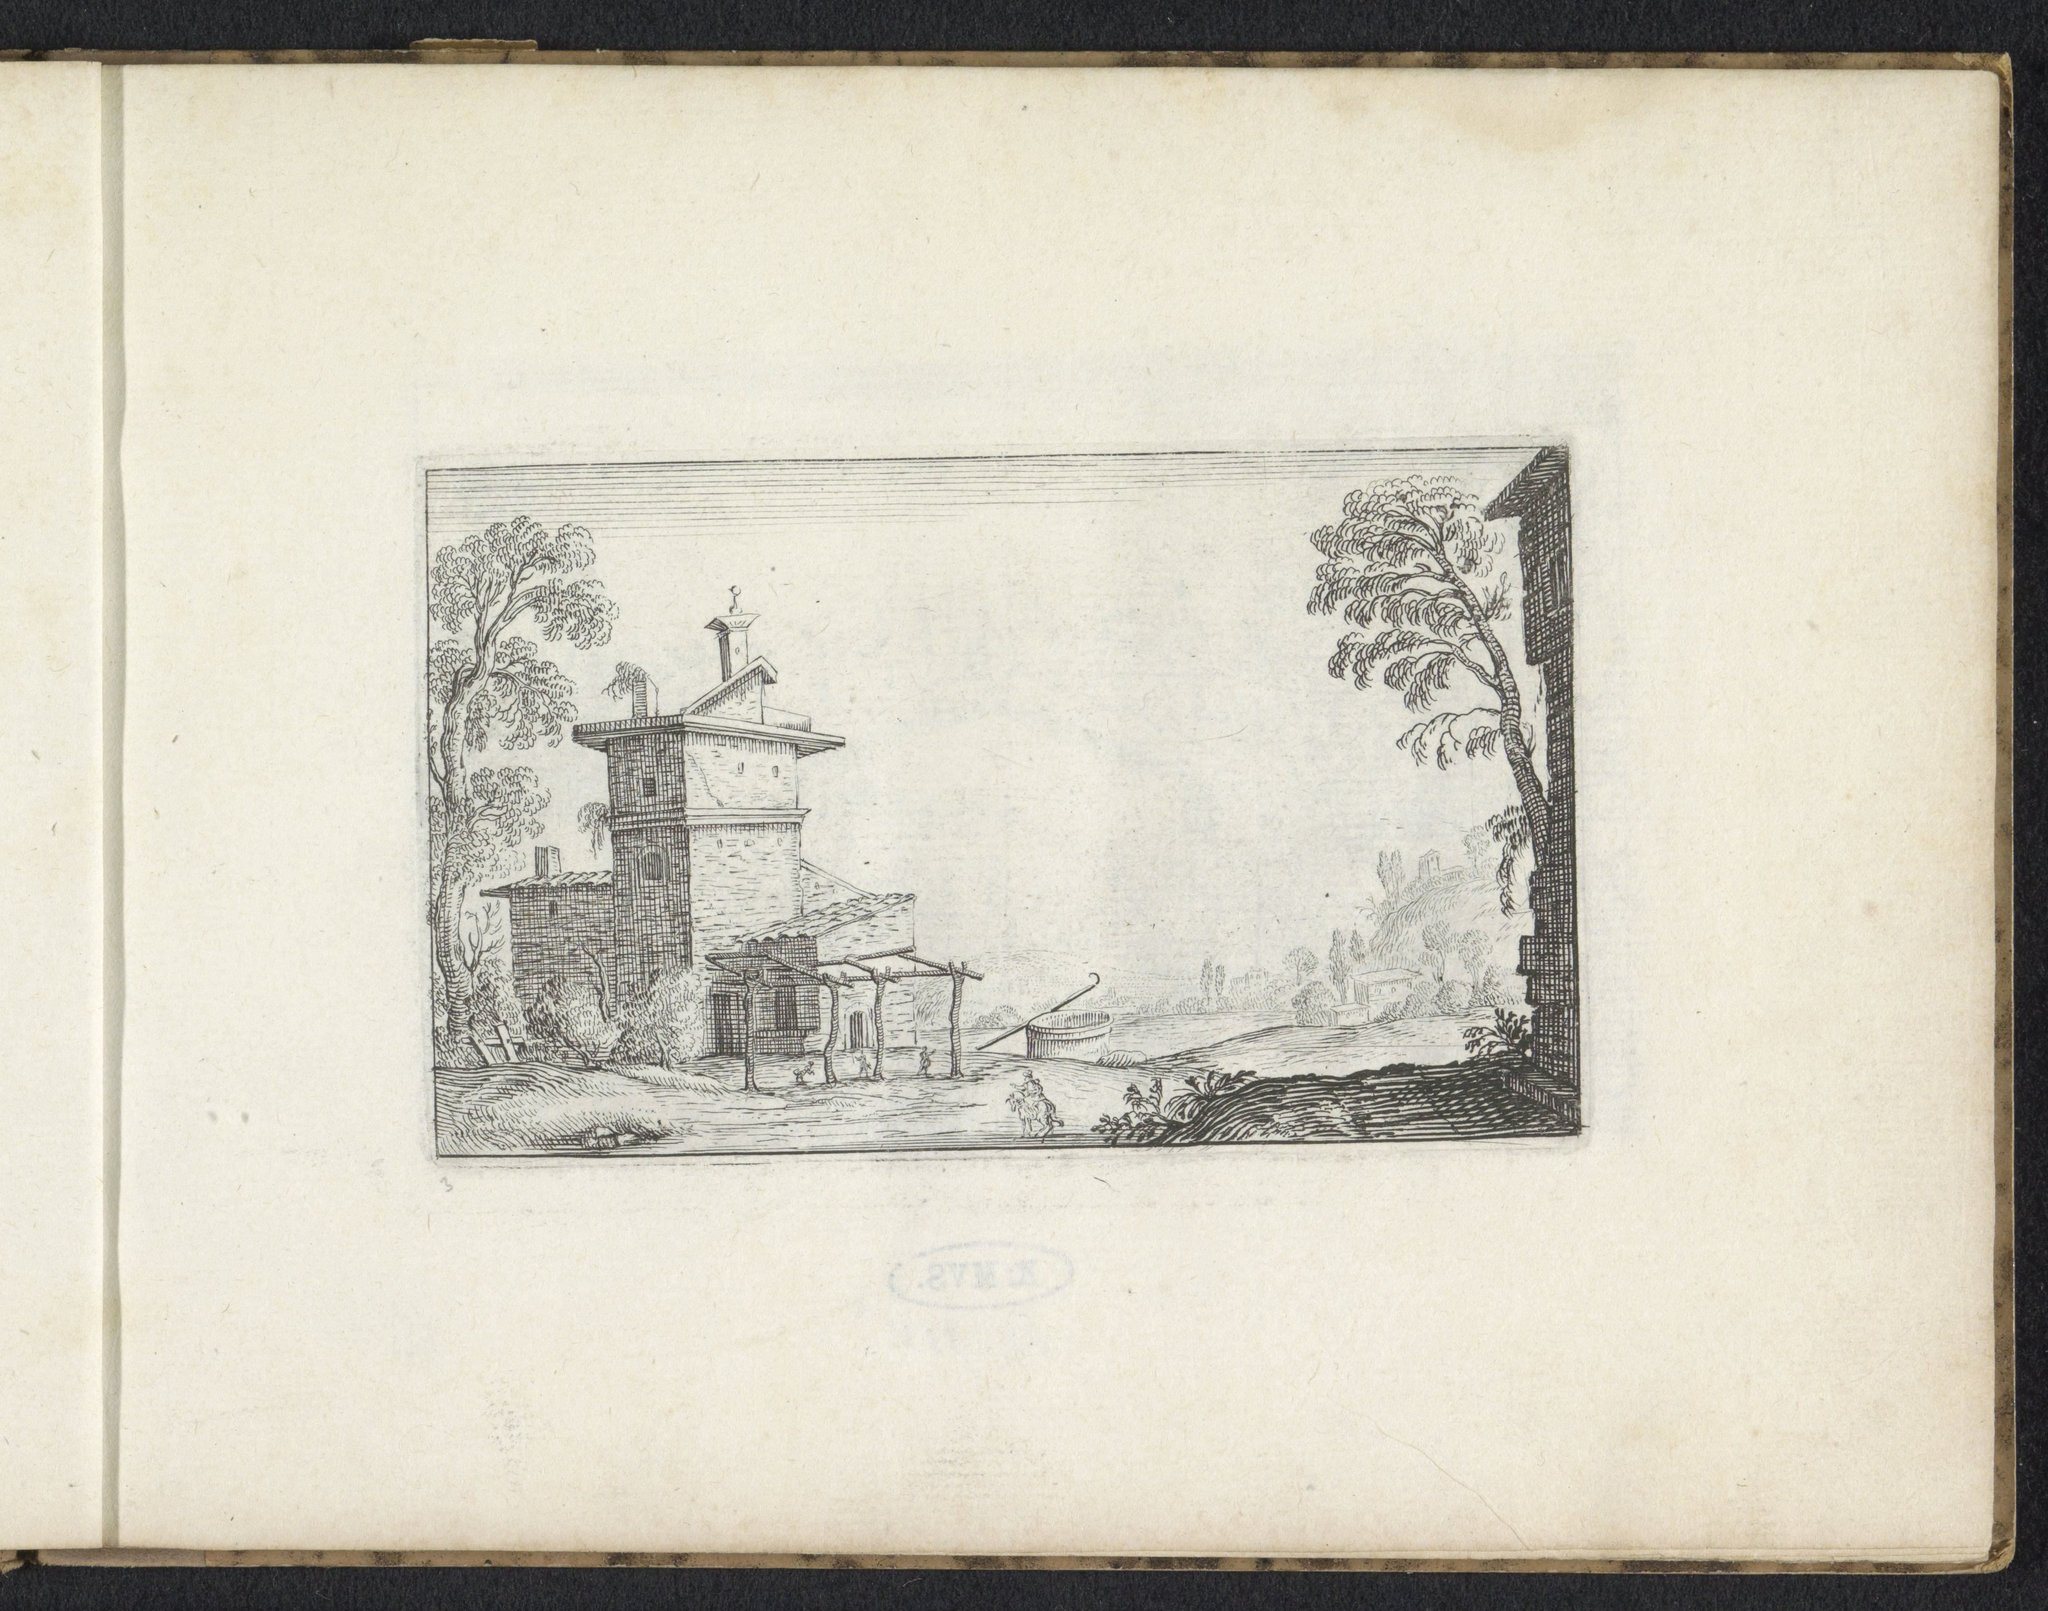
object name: album leaf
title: Landschap met links een huis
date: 1610-1638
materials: paper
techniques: etching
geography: northern netherlands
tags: city-view, and landscape with man-made constructions, landscapes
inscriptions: collector's mark: Lugt 2228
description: Landschap met een links een huis. Op de voorgrond een man te paard. De prent maakt deel uit van een album.